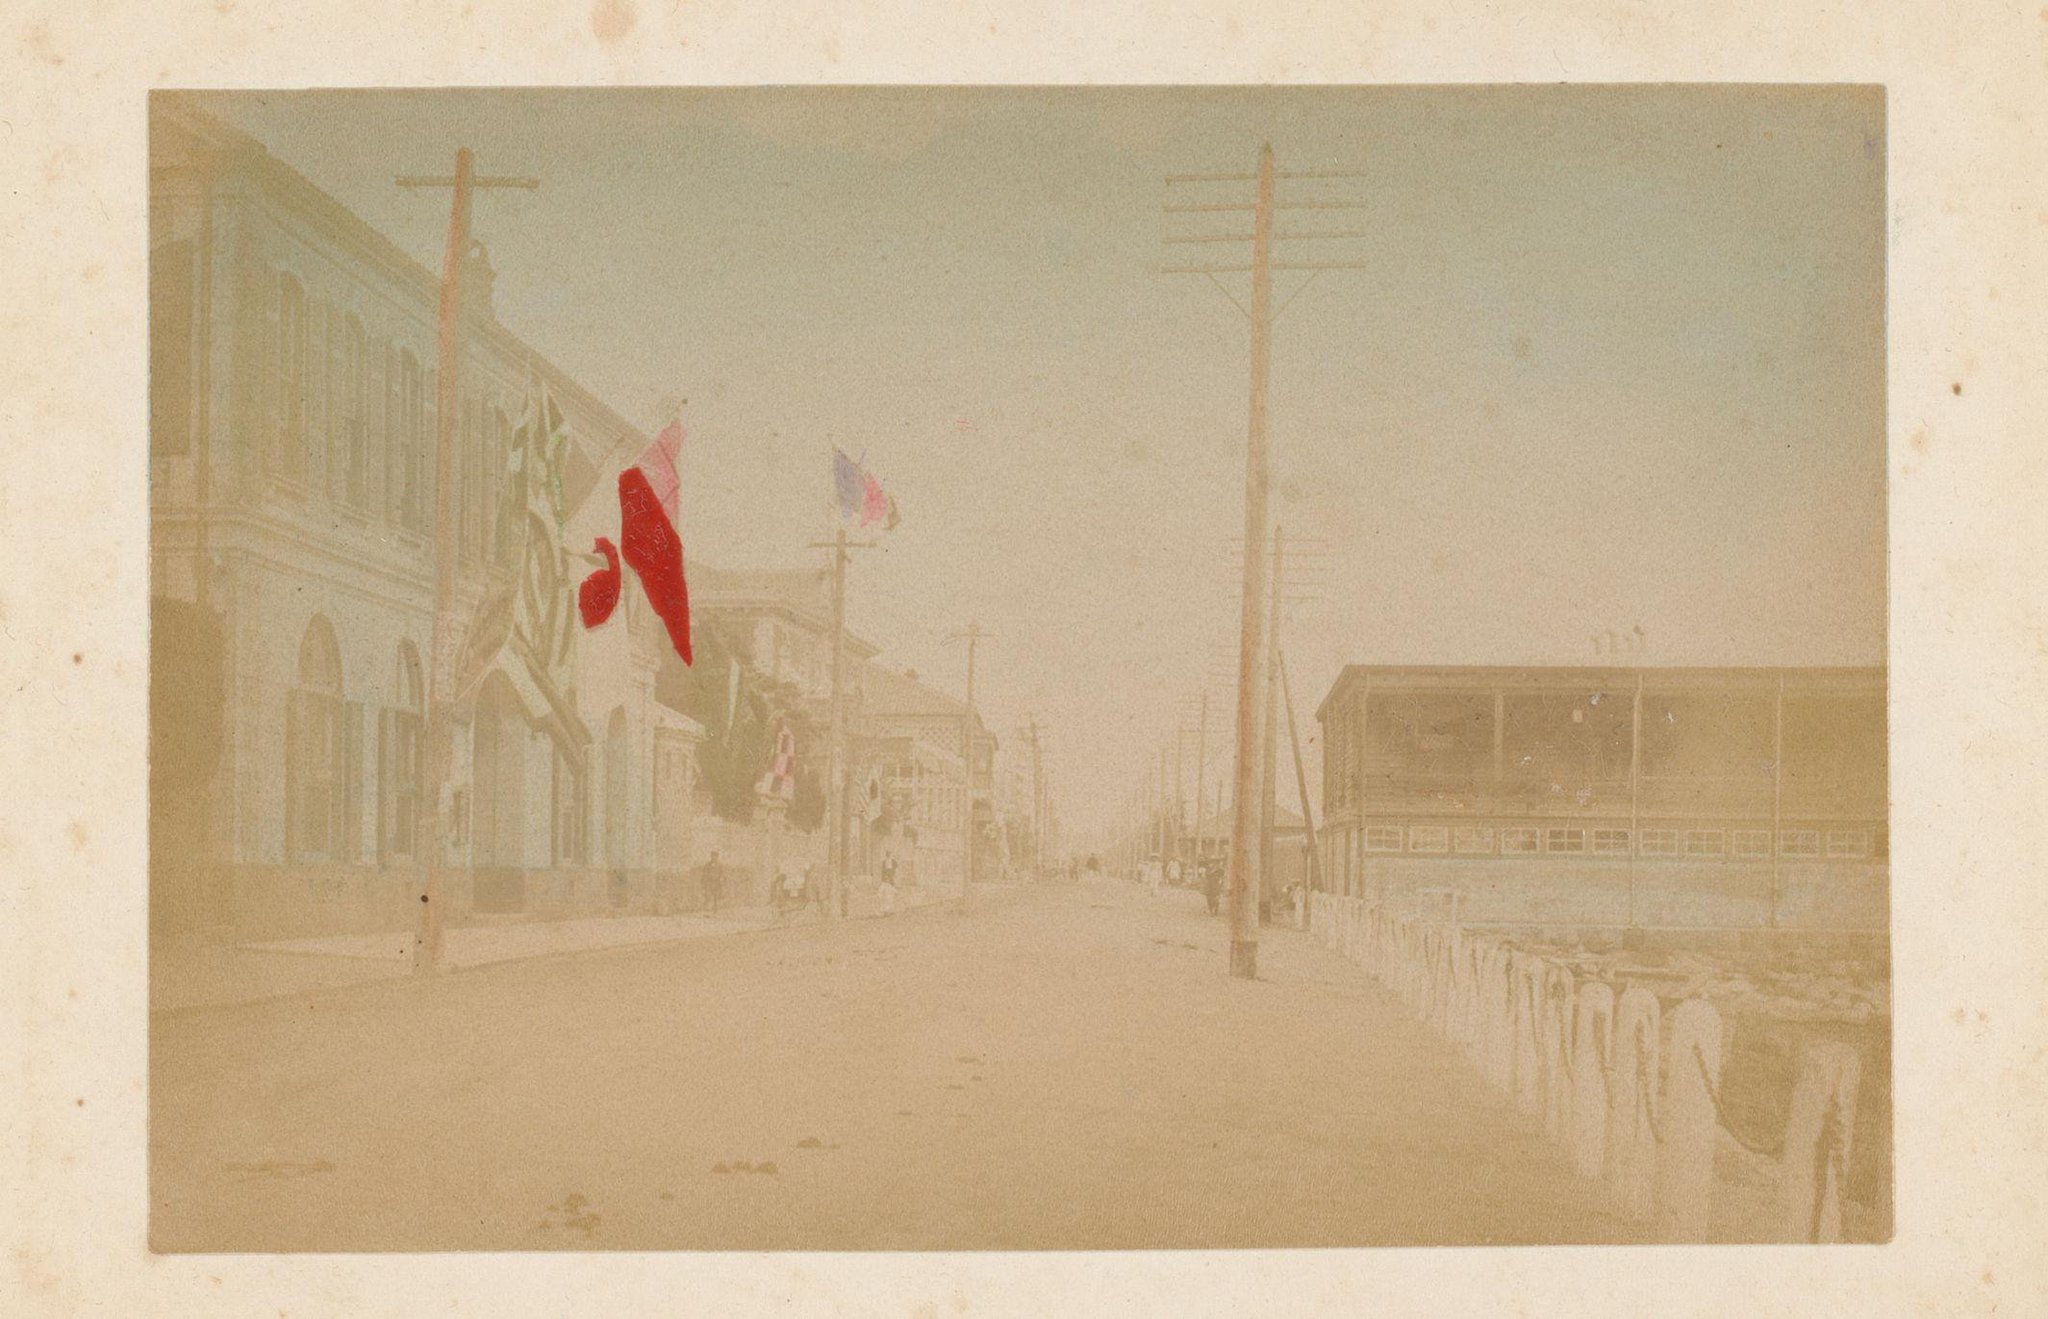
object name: photograph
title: Straat in Japan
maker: Anonymous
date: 1851-1900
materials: paper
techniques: albumen print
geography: japan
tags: street, japan